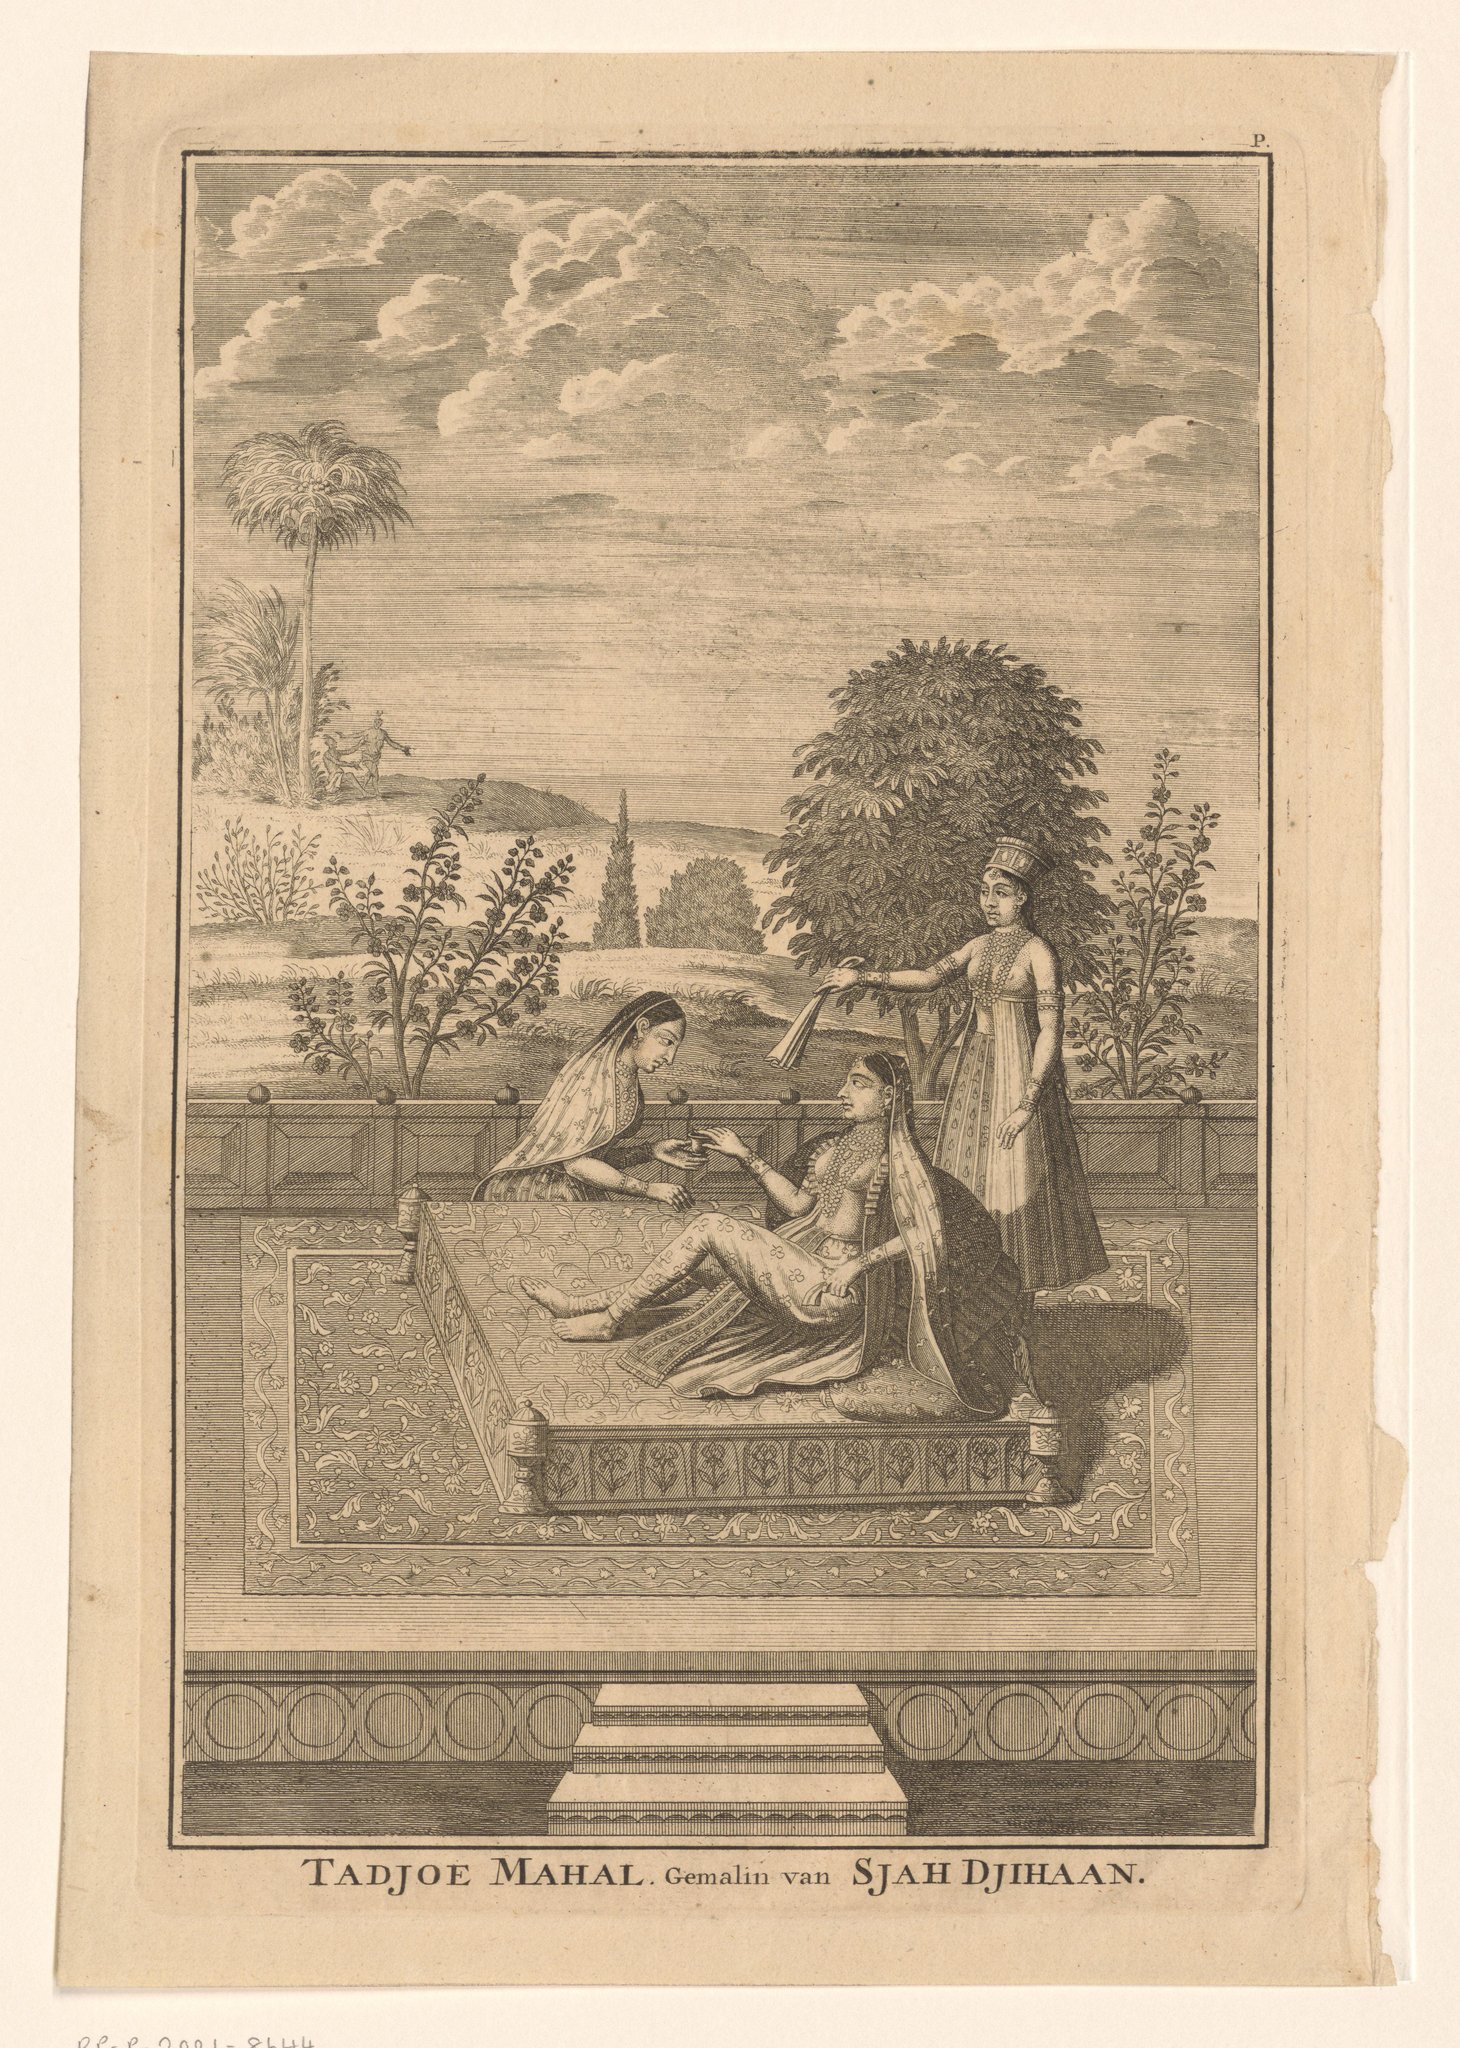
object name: print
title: Portret van Mumtaz Mahal en twee bediendes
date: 1726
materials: paper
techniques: etching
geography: amsterdam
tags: historical persons - bb - woman, princess, house personnel, servants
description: Prent uit: Valentijn, François. Oud en nieuw Oost-Indien, vervattende een naaukeurige en uitvoerige verhandelinge van Nederlands mogentheyd in die gewesten (...). Dordrecht en Amsterdam: Johannes van Braam en Gerard onder de Linden, 1726, dl. 4.